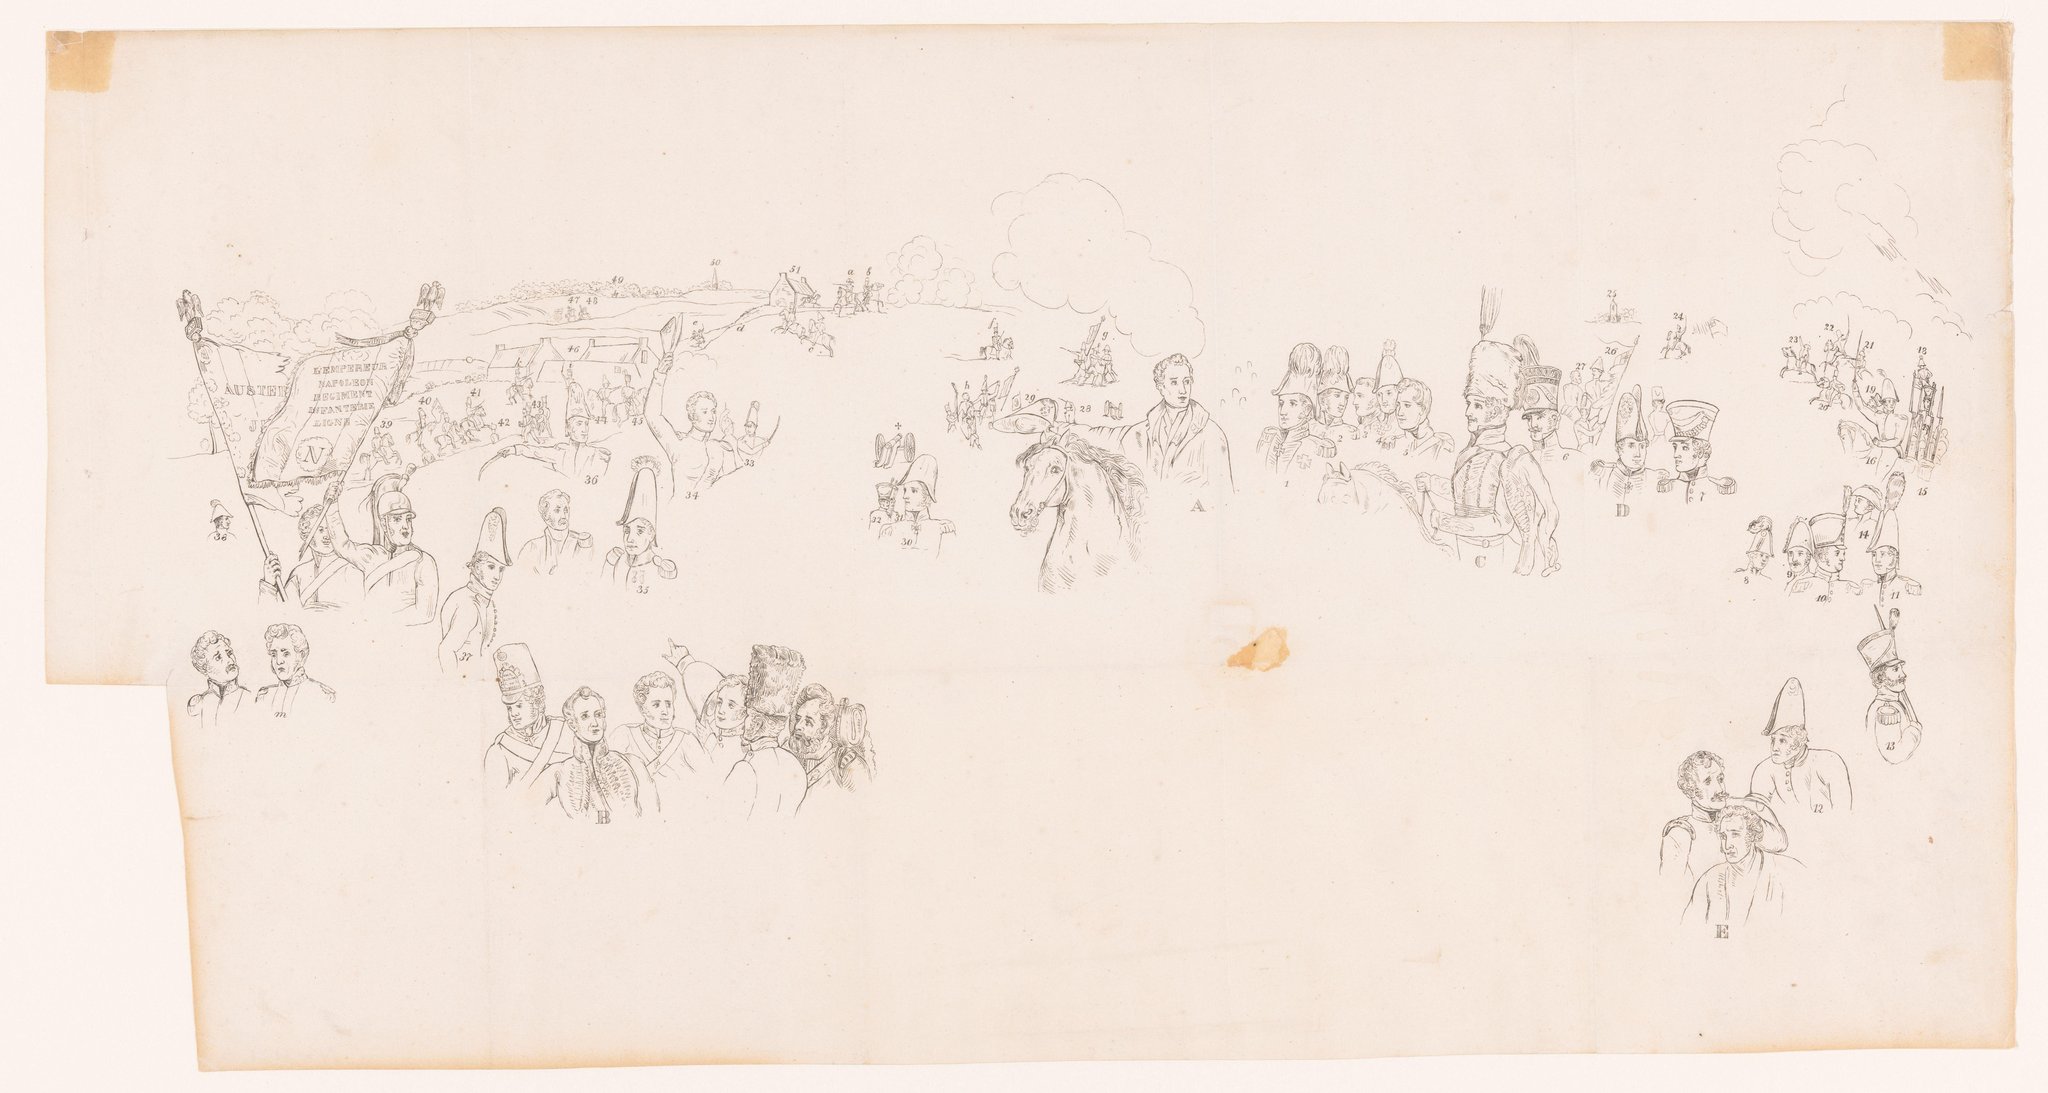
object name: drawing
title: Tekening van het schilderij voorstellende den veldslag bij Waterloo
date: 1825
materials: paper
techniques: printing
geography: haarlem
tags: abcoude, painter, print maker, draughtsman, jan willem pieneman, haarlem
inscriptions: signature: ‘MET & MEYLINK’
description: Tekening behorend bij de beschrijving (NG-1171-B) van het door Pieneman geschilderde 'Slag bij Waterloo'. Personen zijn v.z.v. een nummer of letter.